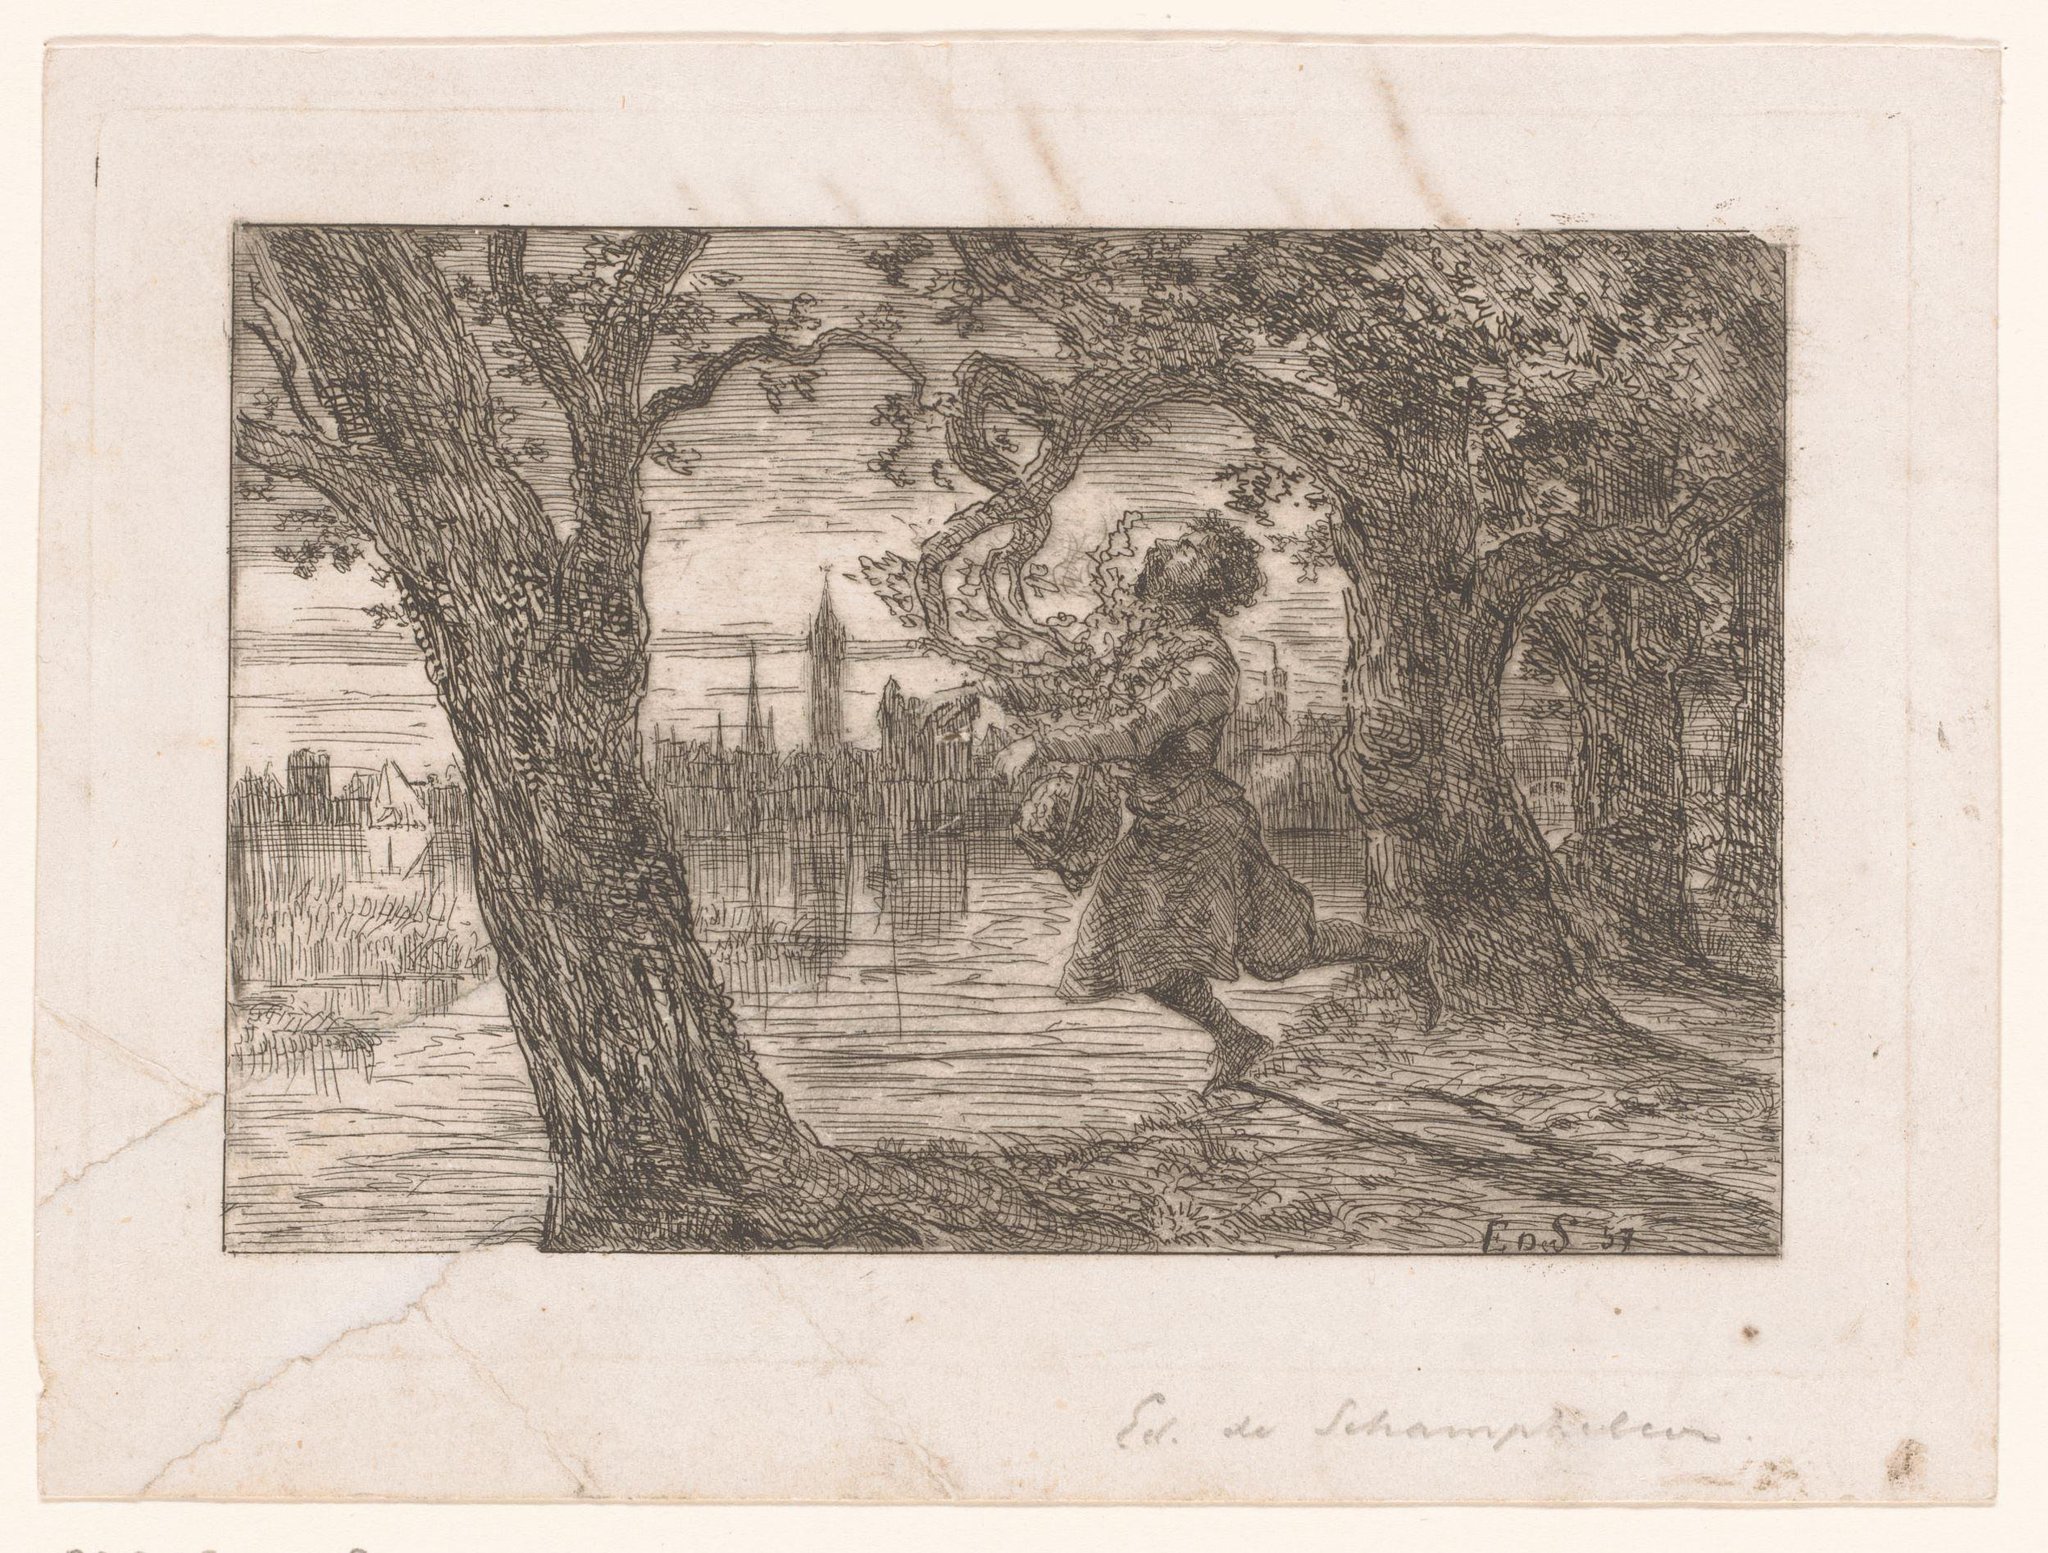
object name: print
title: Struikelende man aan de rand van een bos met stad op de achtergrond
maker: edmond de schampheleer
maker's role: print maker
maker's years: 1824-1899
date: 1857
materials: paper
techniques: etching, intaglio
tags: city-view, and landscape with man-made constructions, trees, forest, wood, falling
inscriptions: collector's mark: Lugt 2228, stamp: ‘SRL’, inscription: ‘La Haye. Exposition des Beaux. Arts, au local en Luken Akademie. Princessegracht. Contenant deux Tableaux. [apediée] par E. de Schampheler 30 rue de Commerce Bruxelles.’